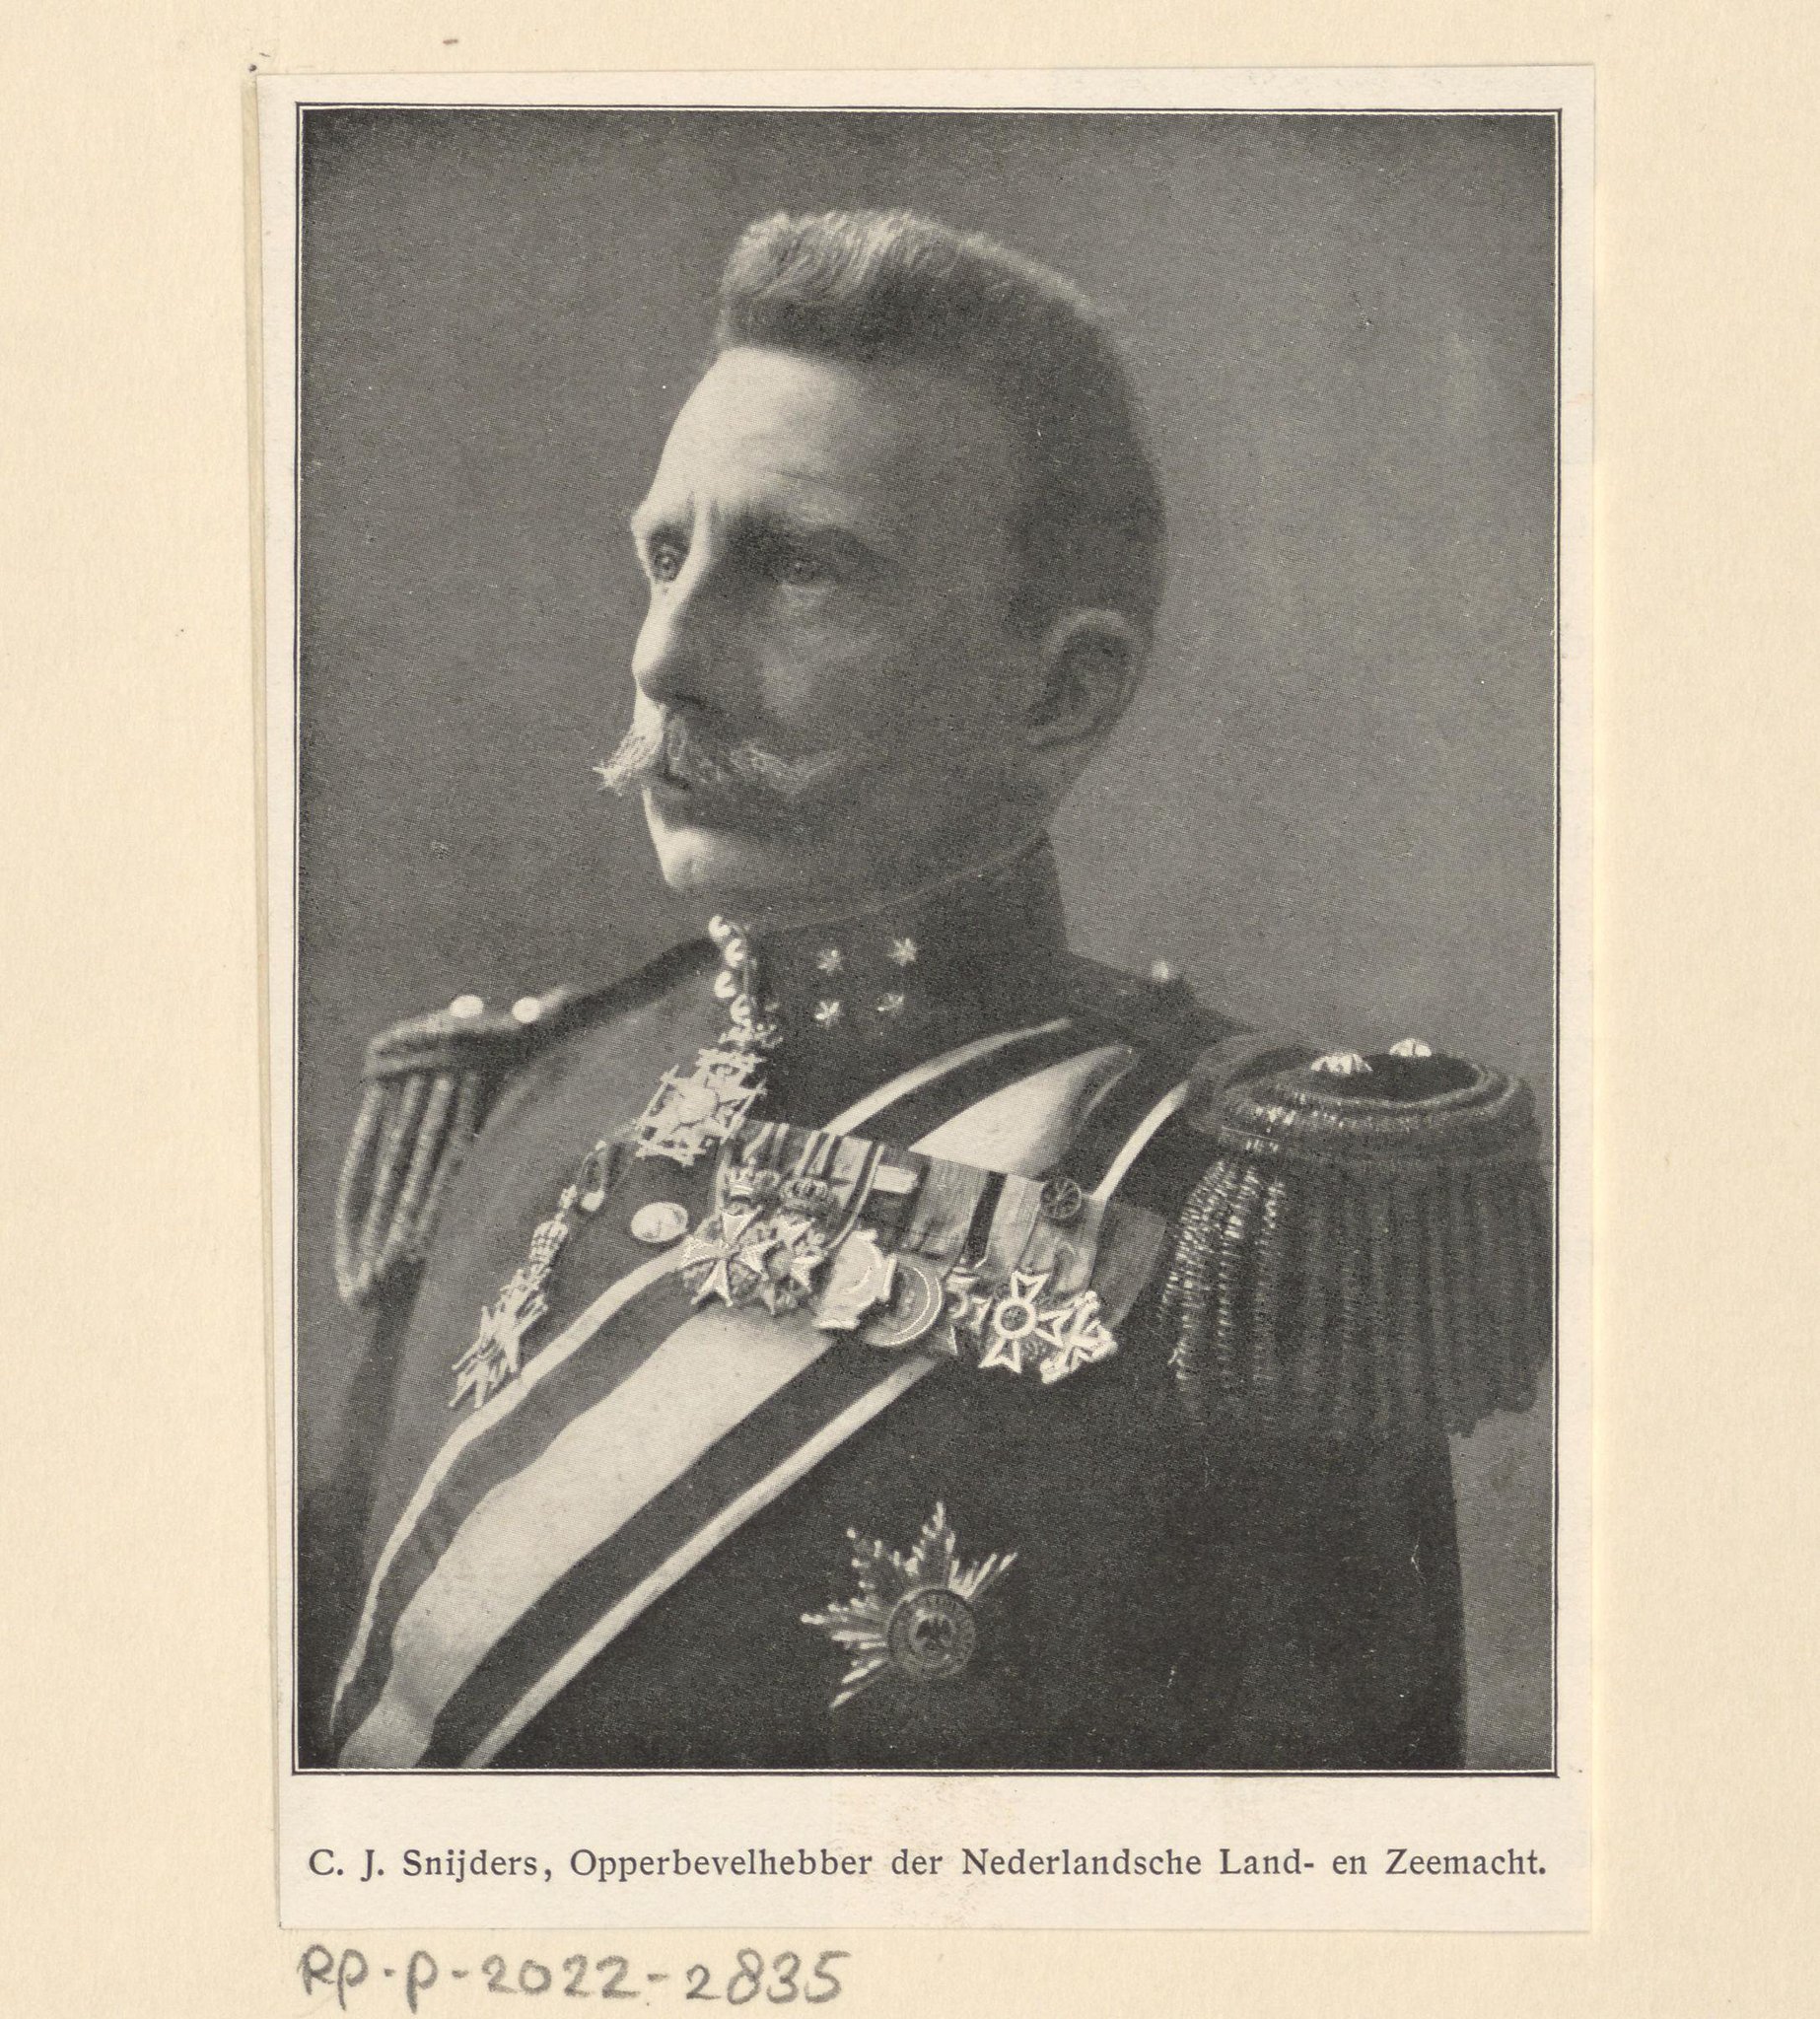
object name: photomechanical print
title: Portret van Cornelis Jacobus Snijders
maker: Anonymous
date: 1914-1970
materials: paper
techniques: letterpress printing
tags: commander-in-chief, general, marshal, historical persons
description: Fotomechanische afdruk uit een onbekende publicatie.